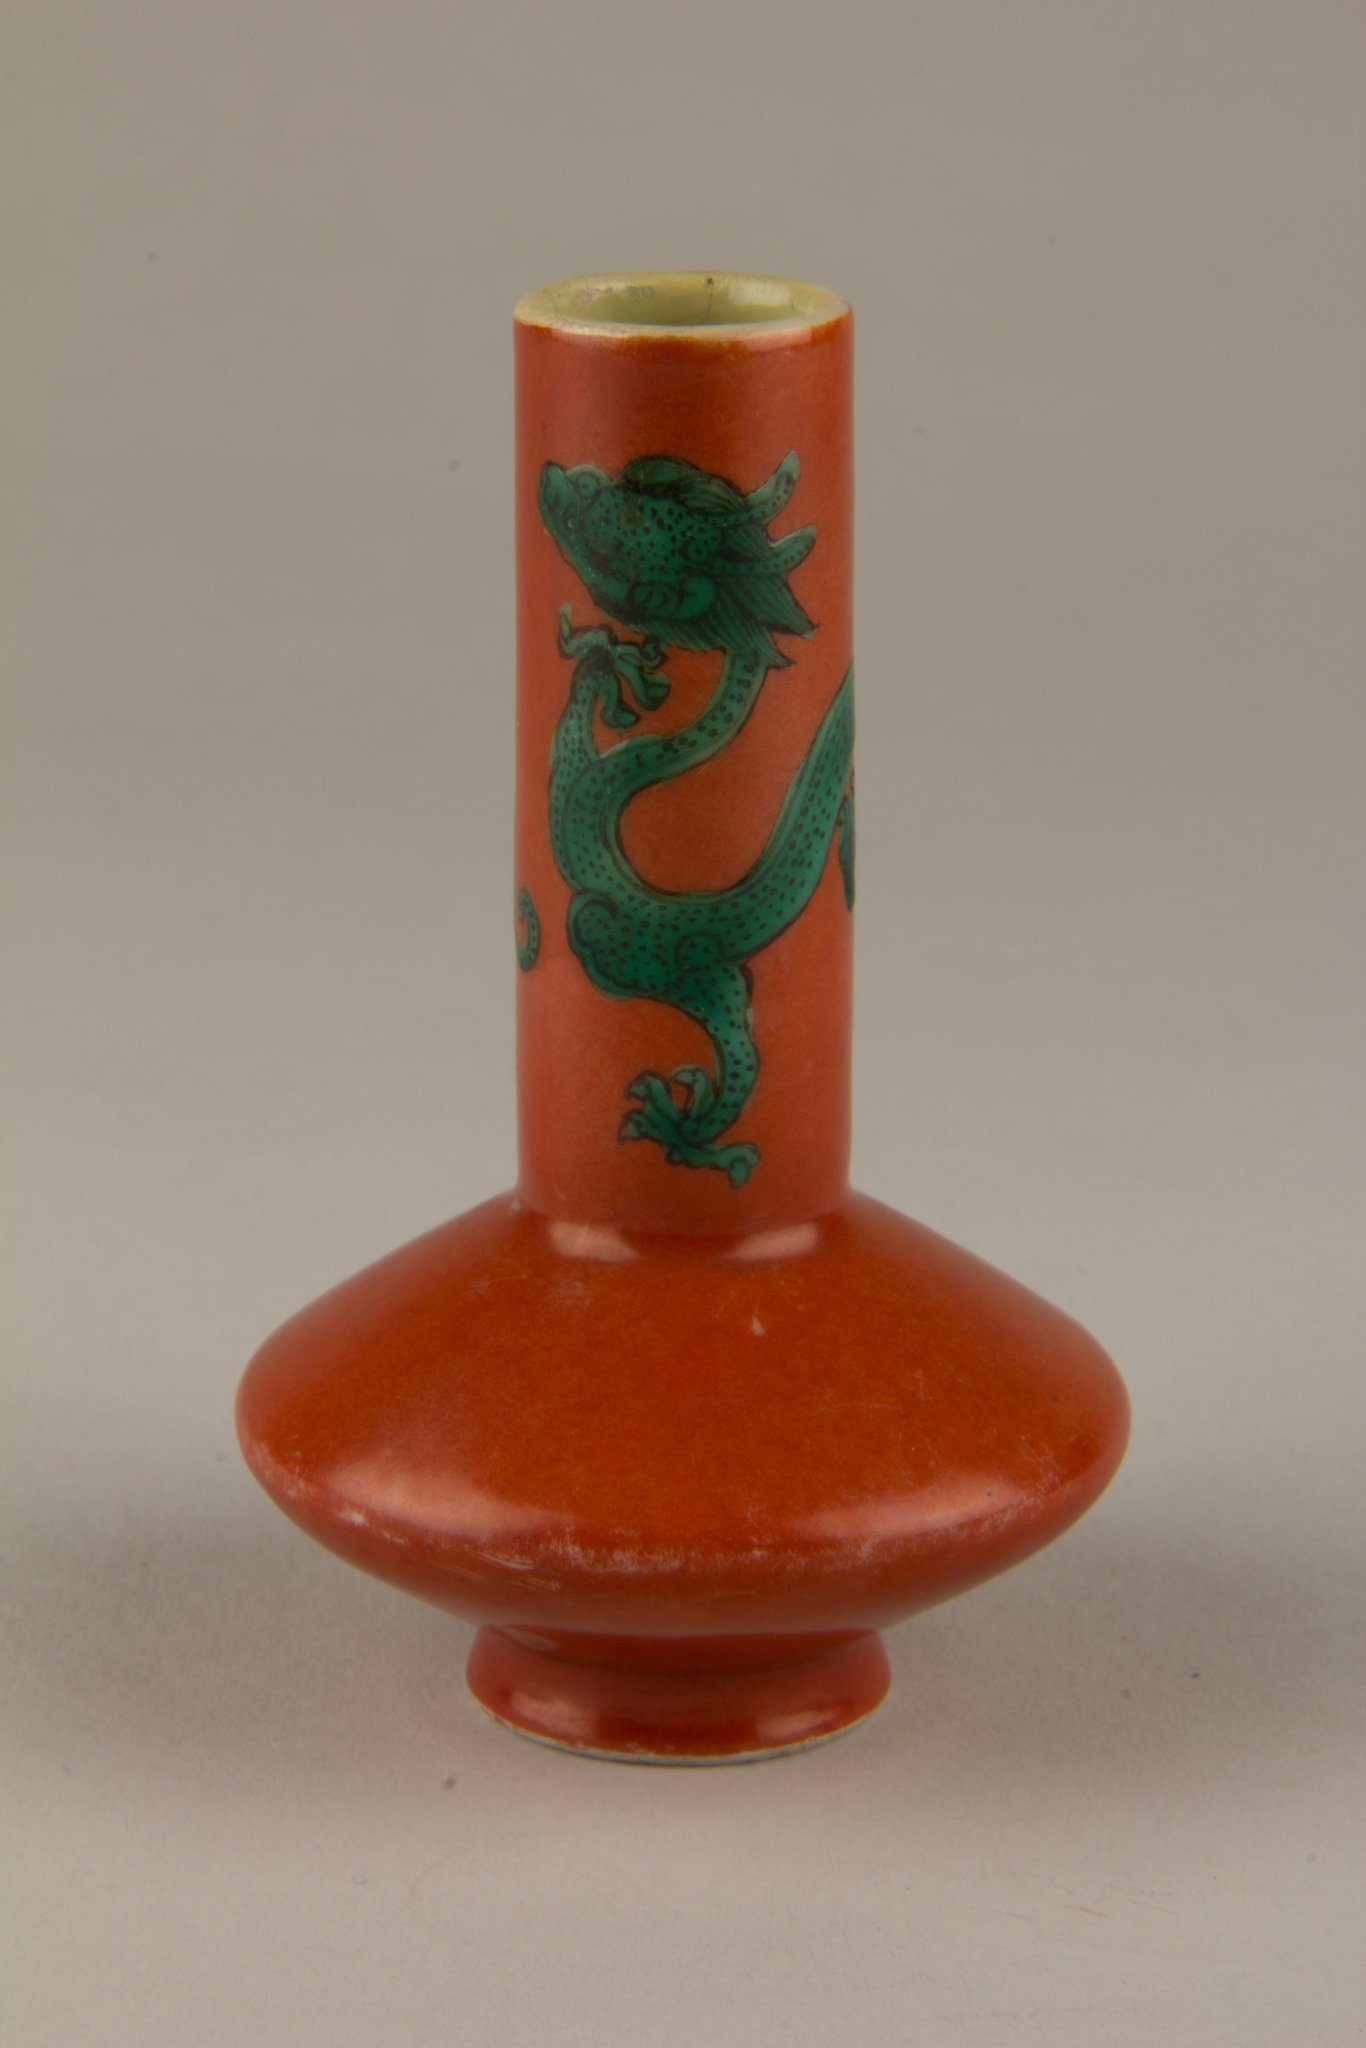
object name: bottle vase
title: Bottle vase with dragon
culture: chinese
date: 1701-1800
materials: enamel, porcelain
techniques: painting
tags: dragons